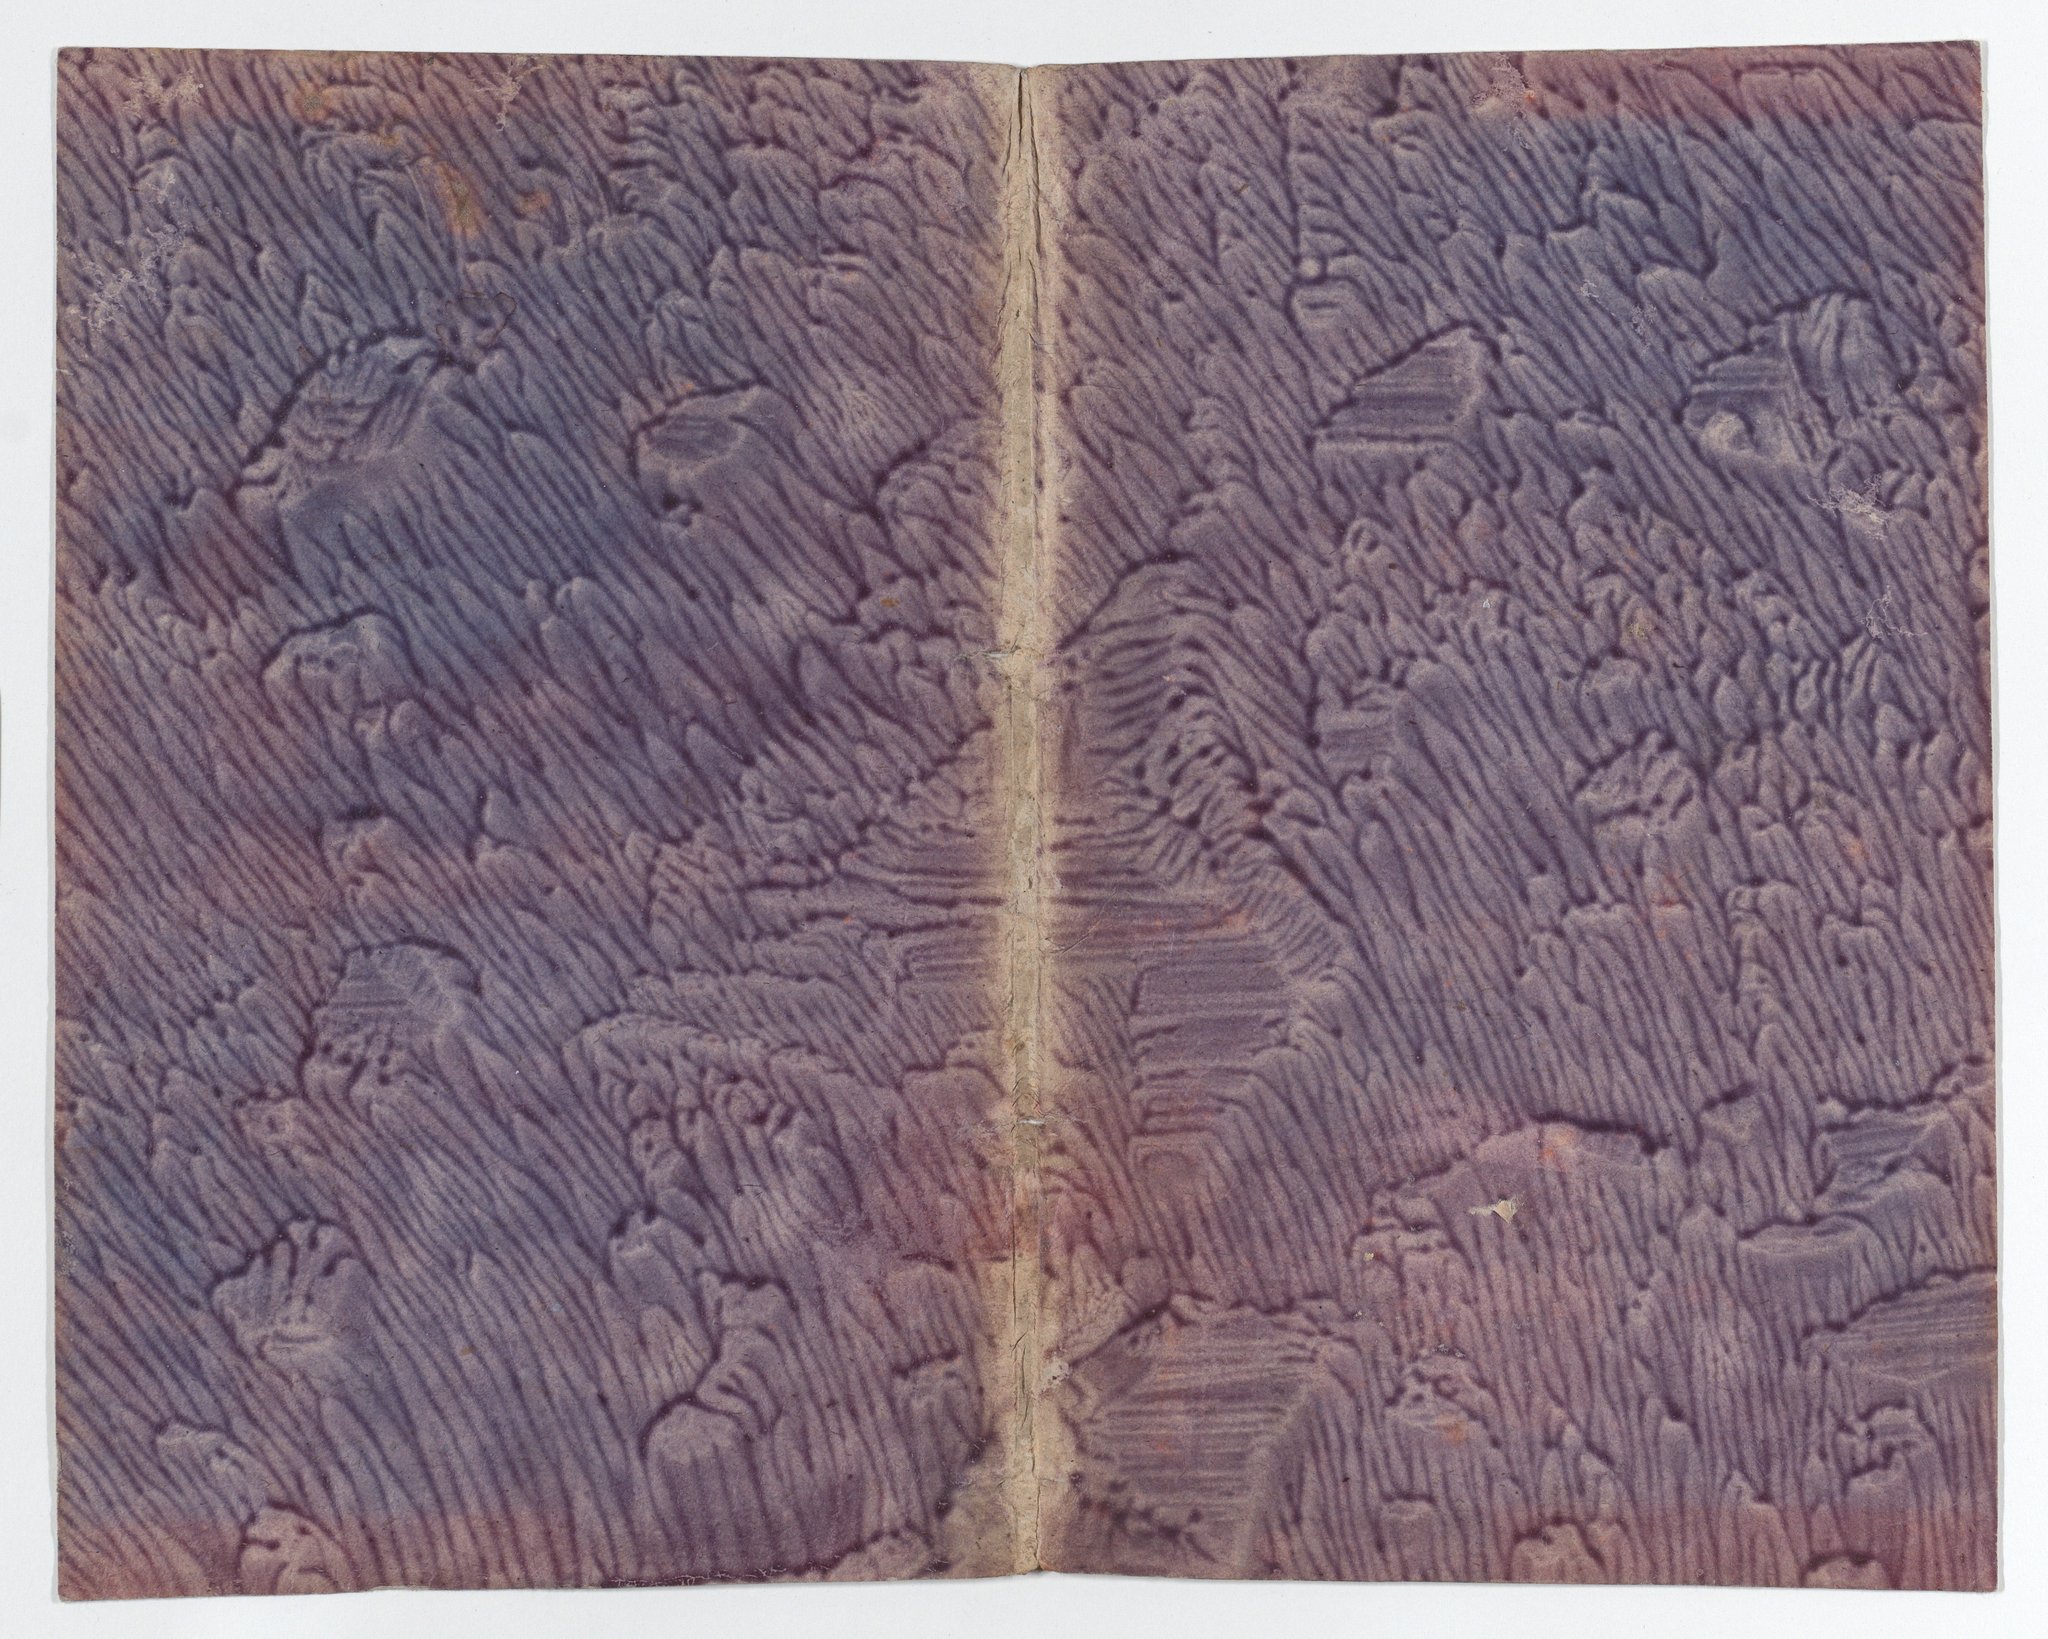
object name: print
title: Purple paste paper book cover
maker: Anonymous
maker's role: artist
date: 1801-1900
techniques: relief print